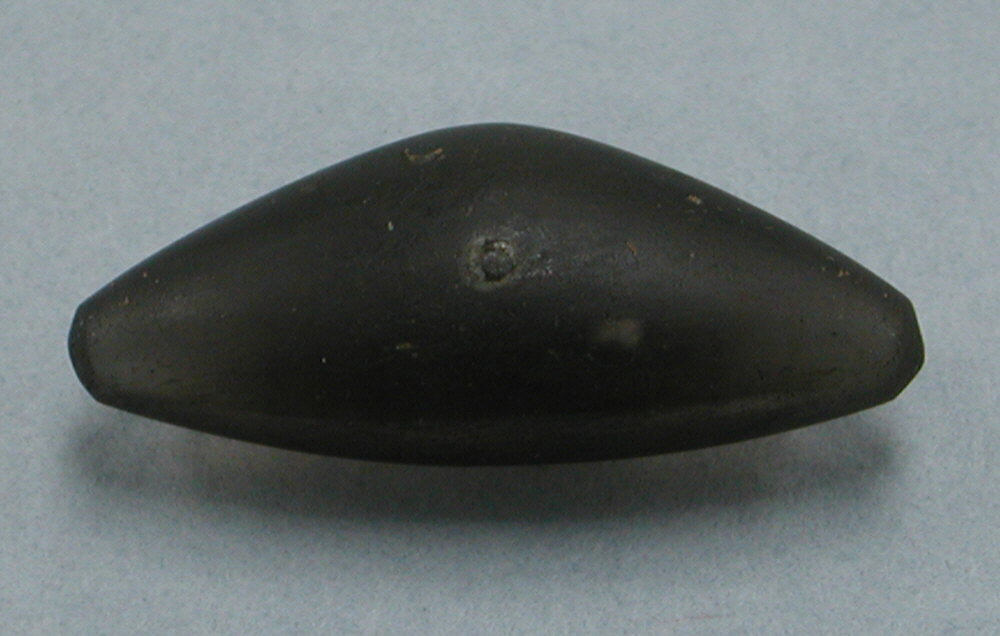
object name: ritual stone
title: Stone Pulidor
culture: mexican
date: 1501-1600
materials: stone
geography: mexico